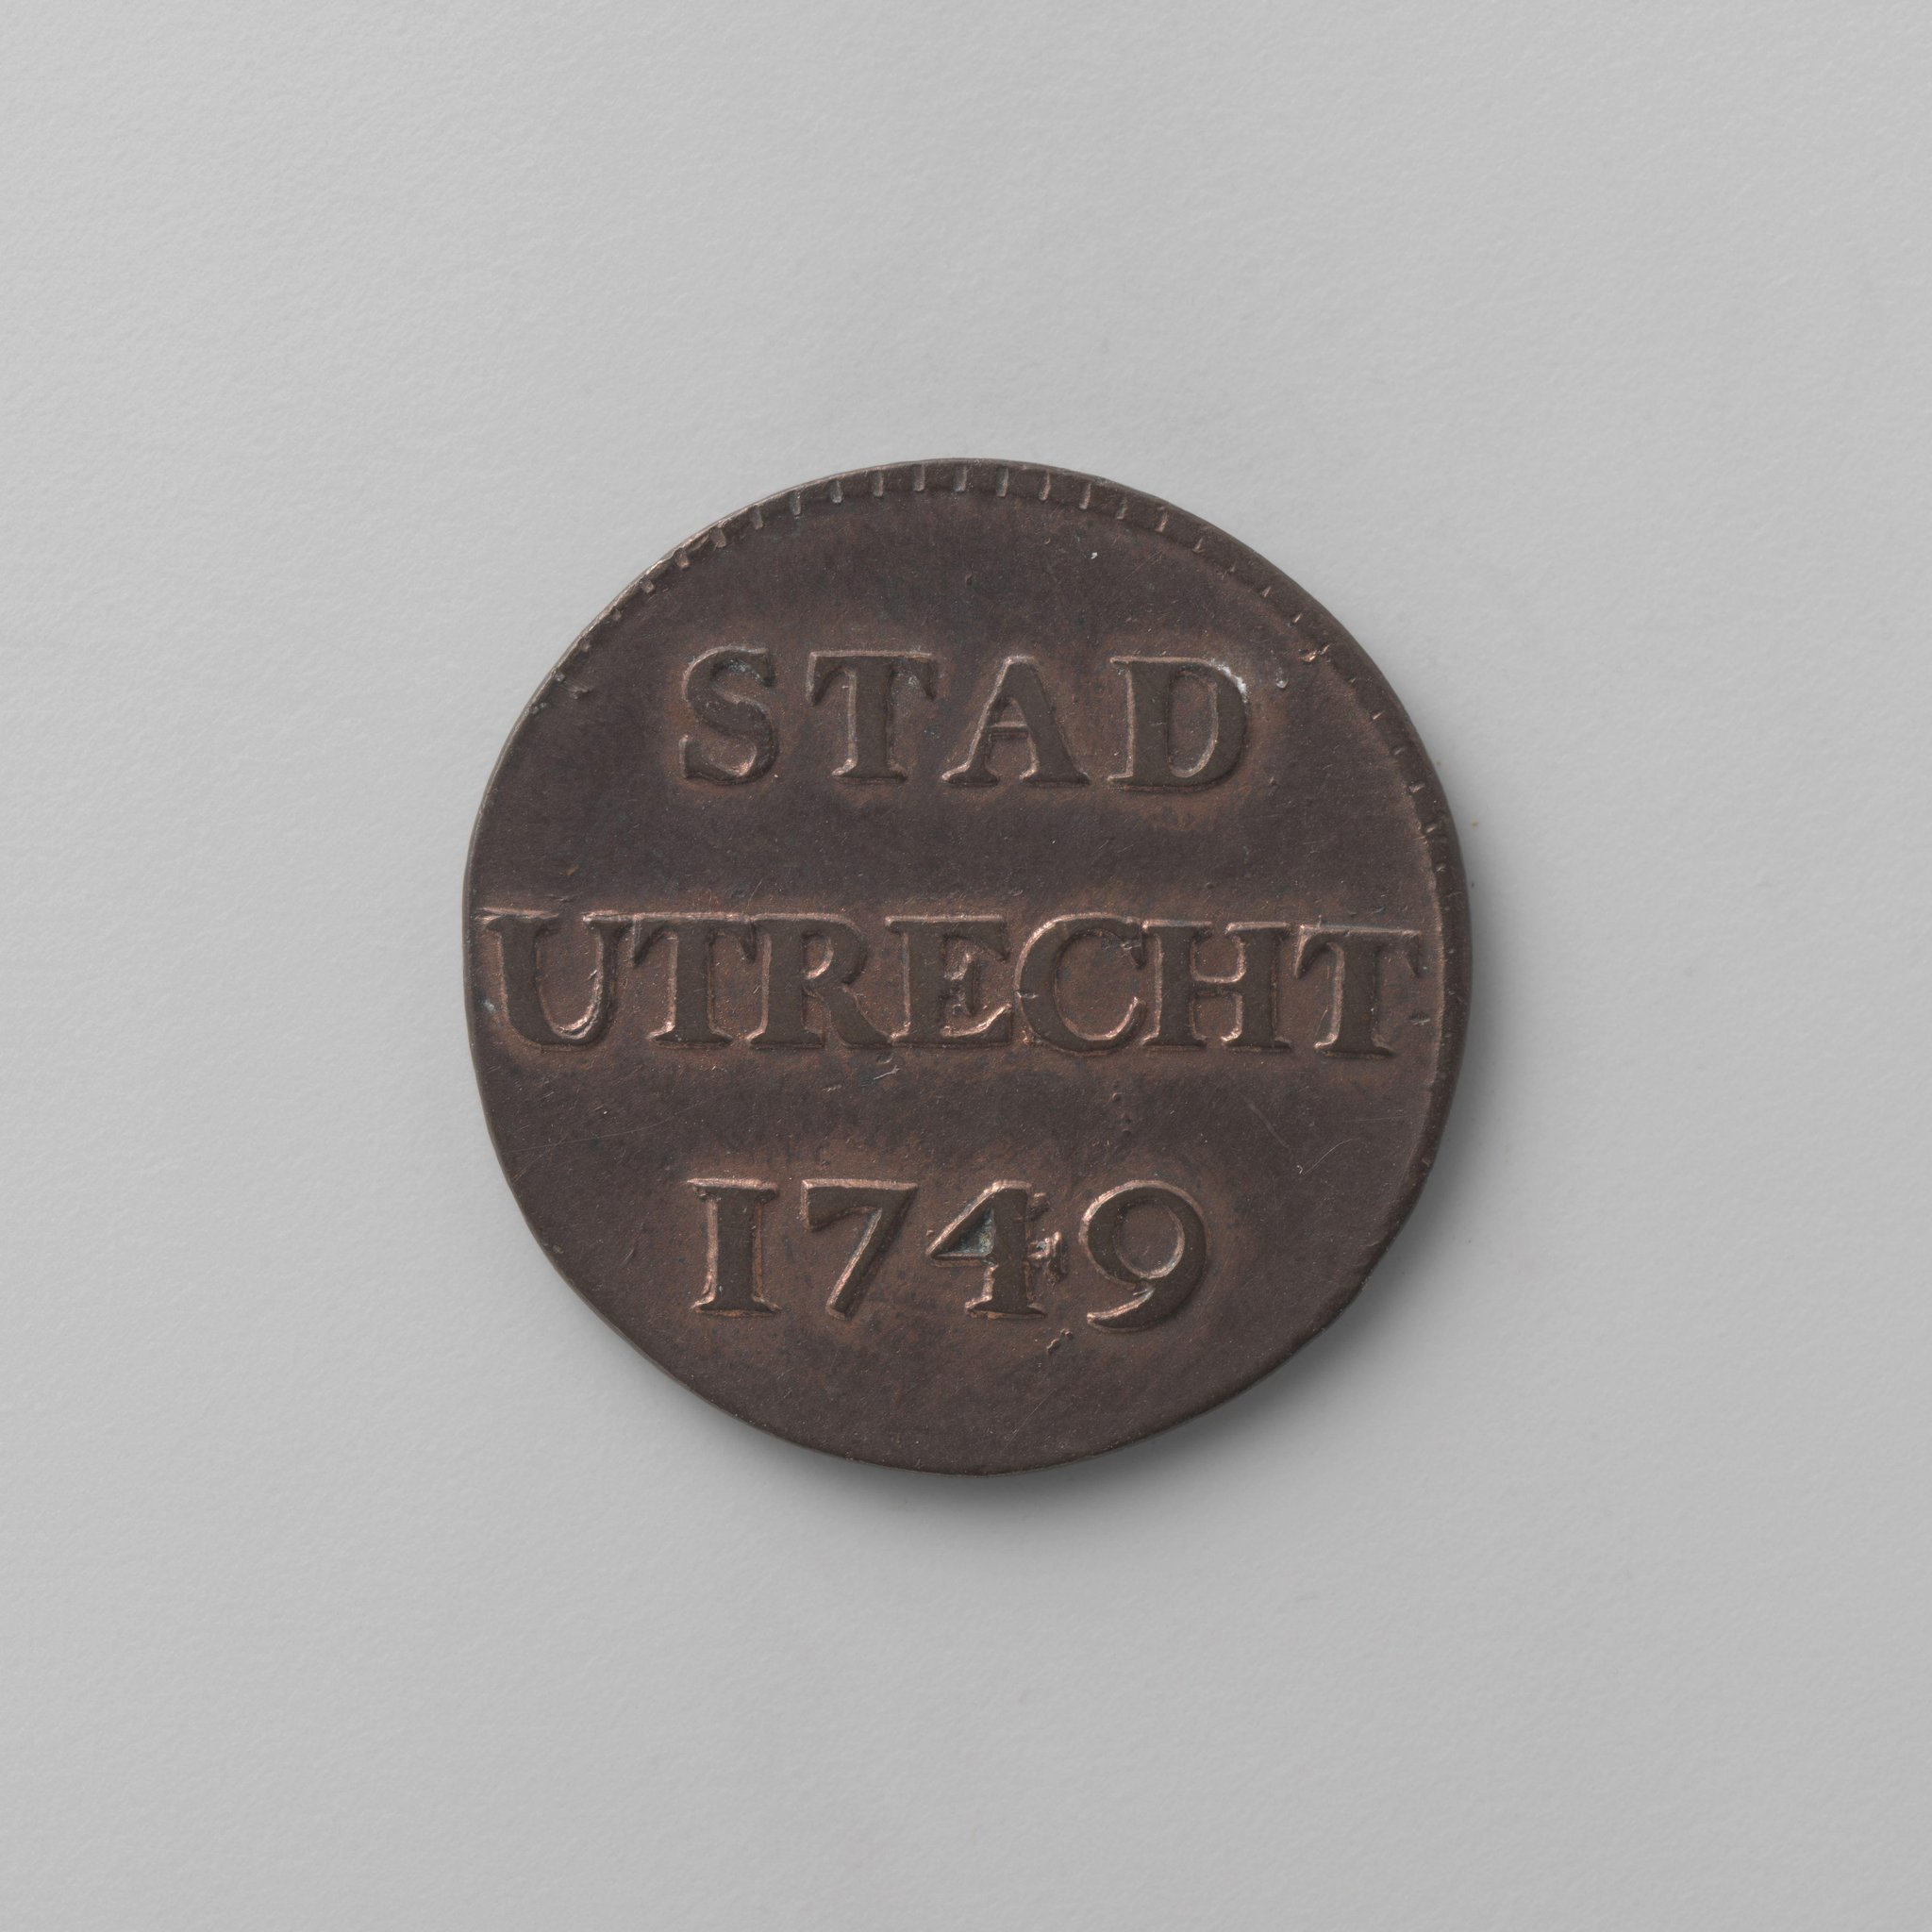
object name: coin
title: Stad Utrecht, duit, 1749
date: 1749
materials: copper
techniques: striking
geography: utrecht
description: Koperen munt. Voorzijde: gekroond stedelijk wapenschild, gehouden door twee leeuwen met in afsnede dunne lijn, waaronder een versierde accolade met een grote schelp. Keerzijde: opschrift in twee regels, waaronder jaartal. Jaartal met Romeinse I.